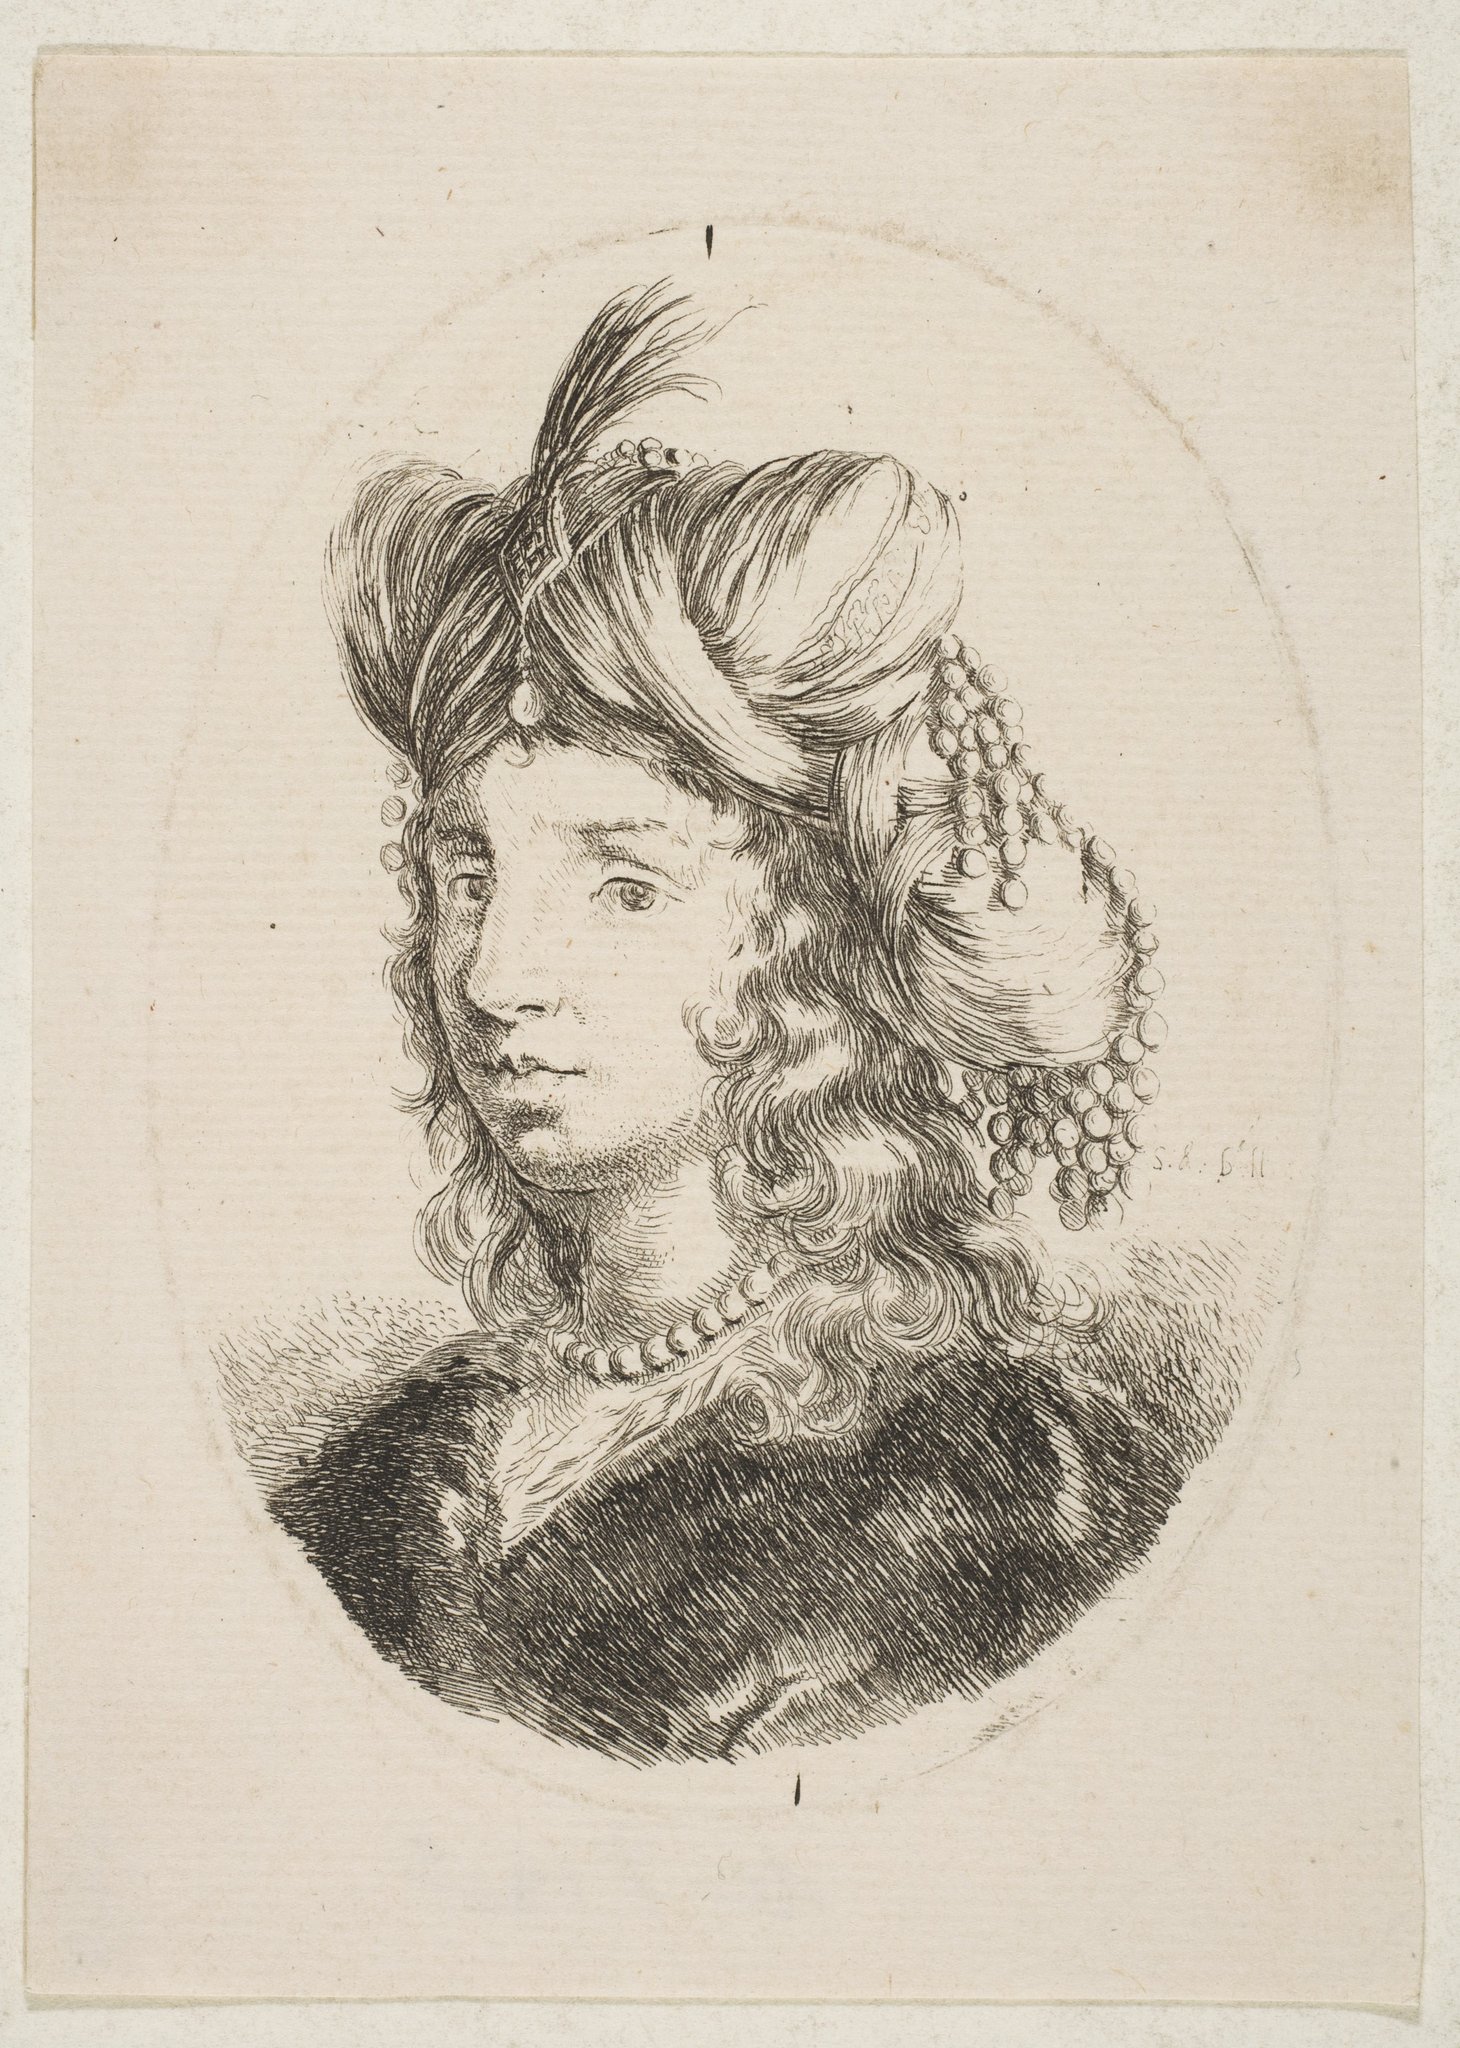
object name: print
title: Sultana wearing a pearl necklace and a turban, from 'Several heads in the Persian style' (Plusieurs têtes coiffées à la persienne)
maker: stefano della bella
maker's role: artist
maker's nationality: italian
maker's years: 1610-1664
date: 1649-1650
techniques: etching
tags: portraits,women